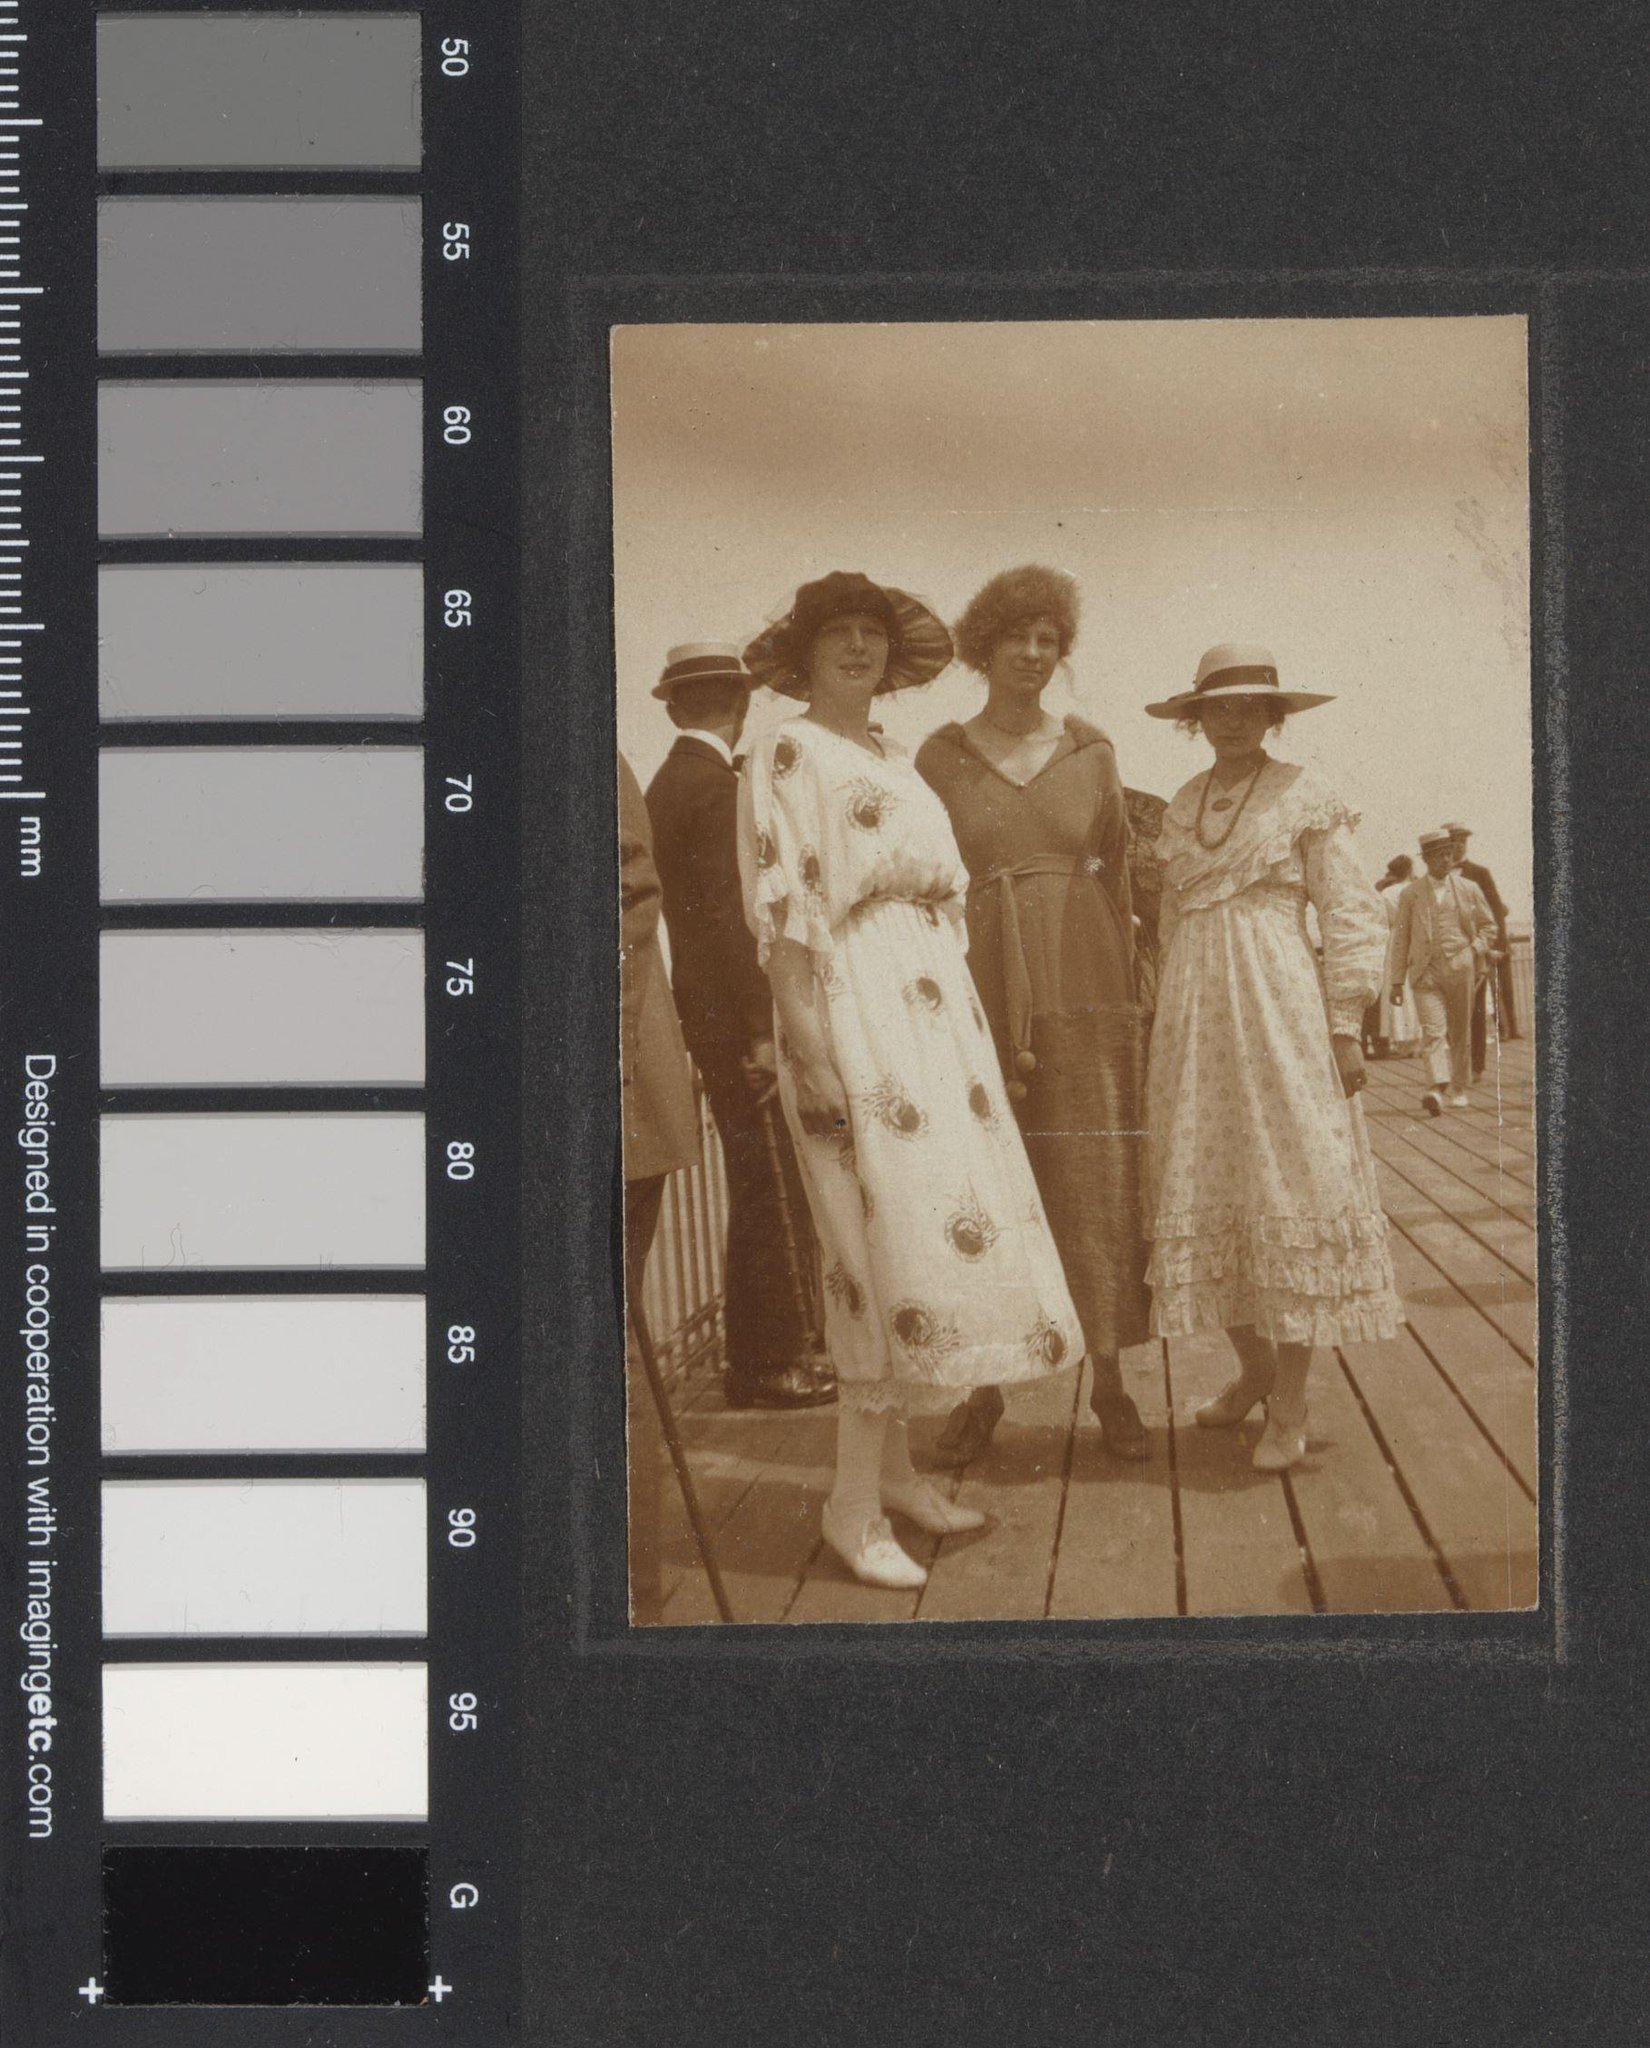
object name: photograph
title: Drie vrouwen op de pier in Scheveningen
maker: Anonymous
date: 1920-1925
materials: paper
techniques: collodion silver print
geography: south holland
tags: adult woman, pier, quay, wharf